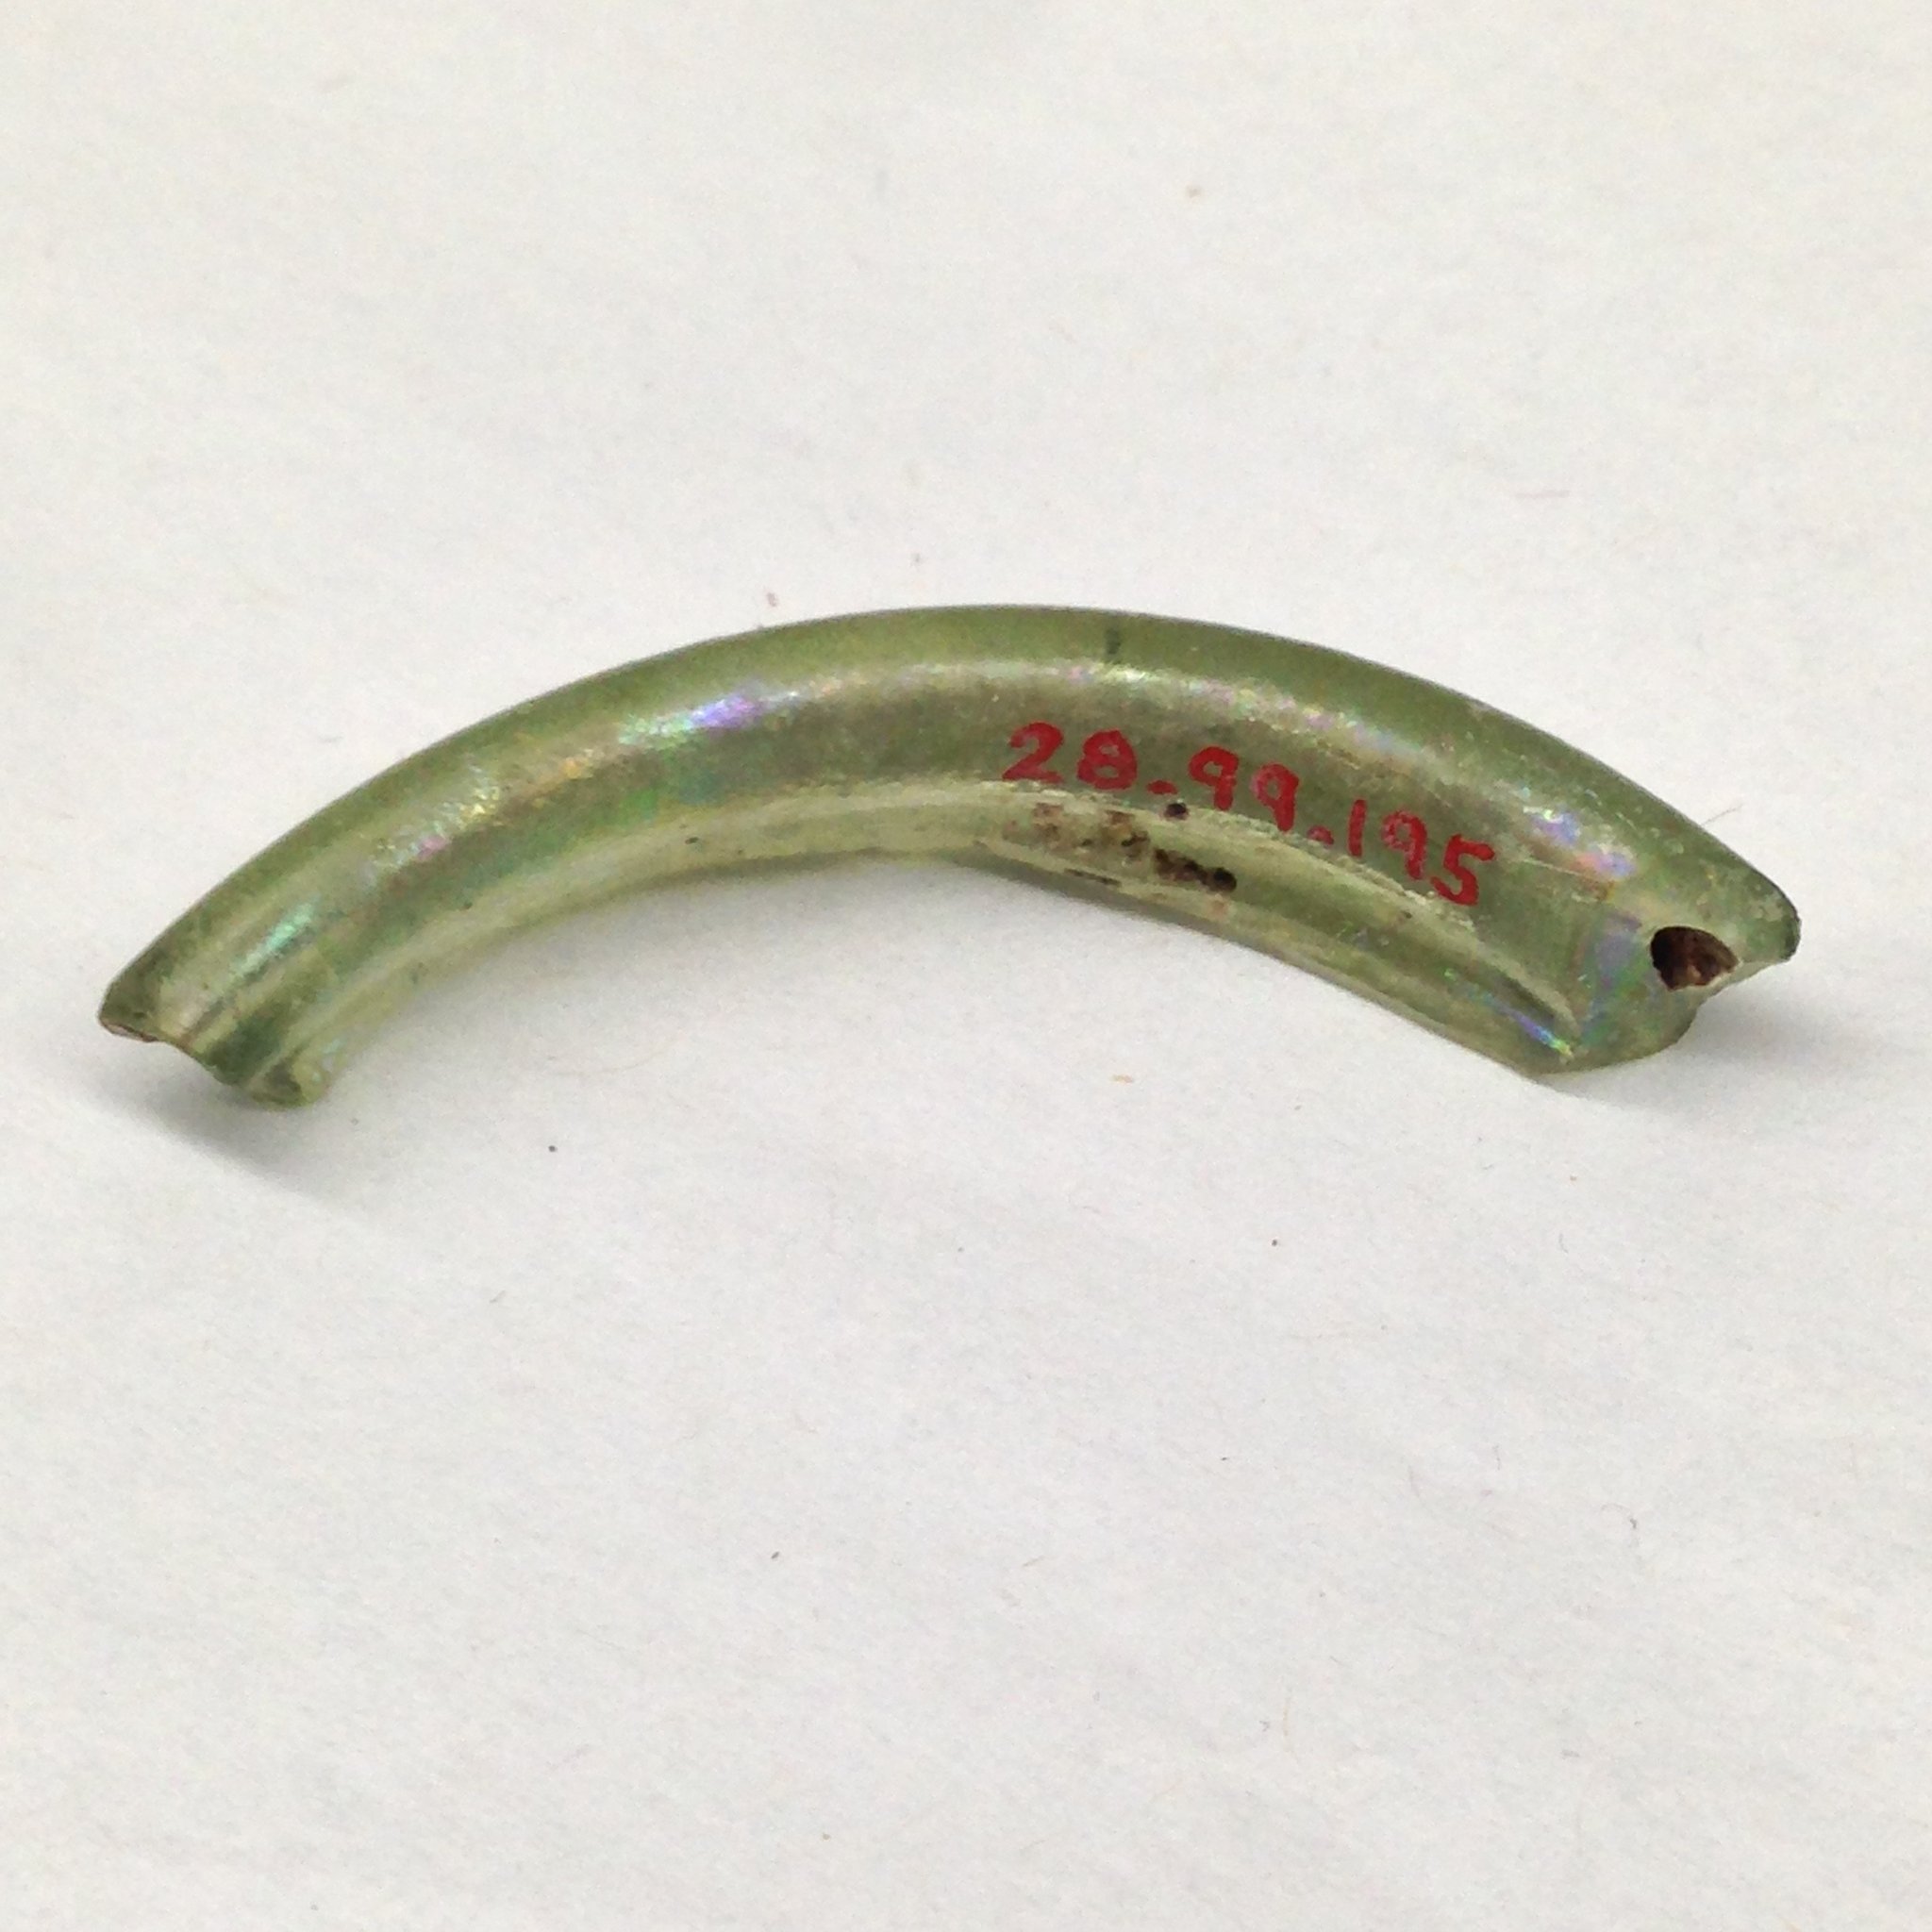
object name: fragment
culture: european or middle eastern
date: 1150-1250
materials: ceramic, glass